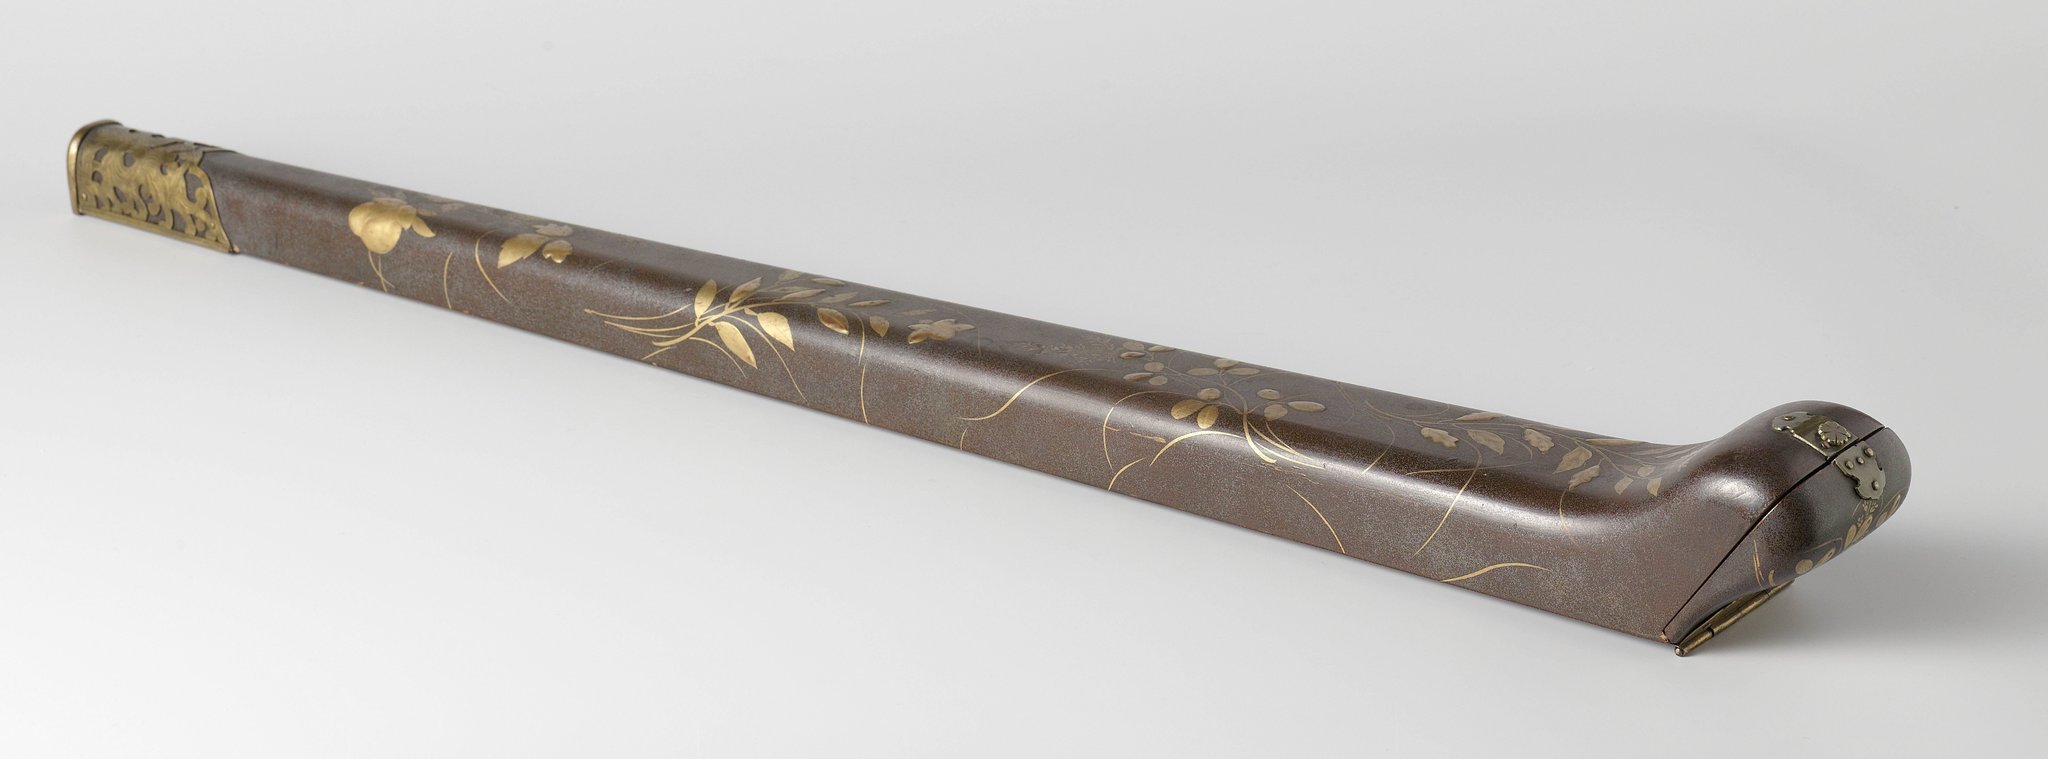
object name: box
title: Japans pijpfoudraal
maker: Anonymous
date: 1700-1740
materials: copper, gold, lacquer, wood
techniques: lacquer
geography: japan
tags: foliage ~ ornament, japan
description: Doos voor twee lange pijpen, de vorm van de pijpen volgend. De doos kan met een scharnierend deksel geopend worden aan de kant van pijpenkop. Gedecoreerd met bloemtakken in goud-makie op een nashiji-ondergrond. Scharnier, sluiting en beslag (aan het uiteinde van de doos) van gegraveerd koper.